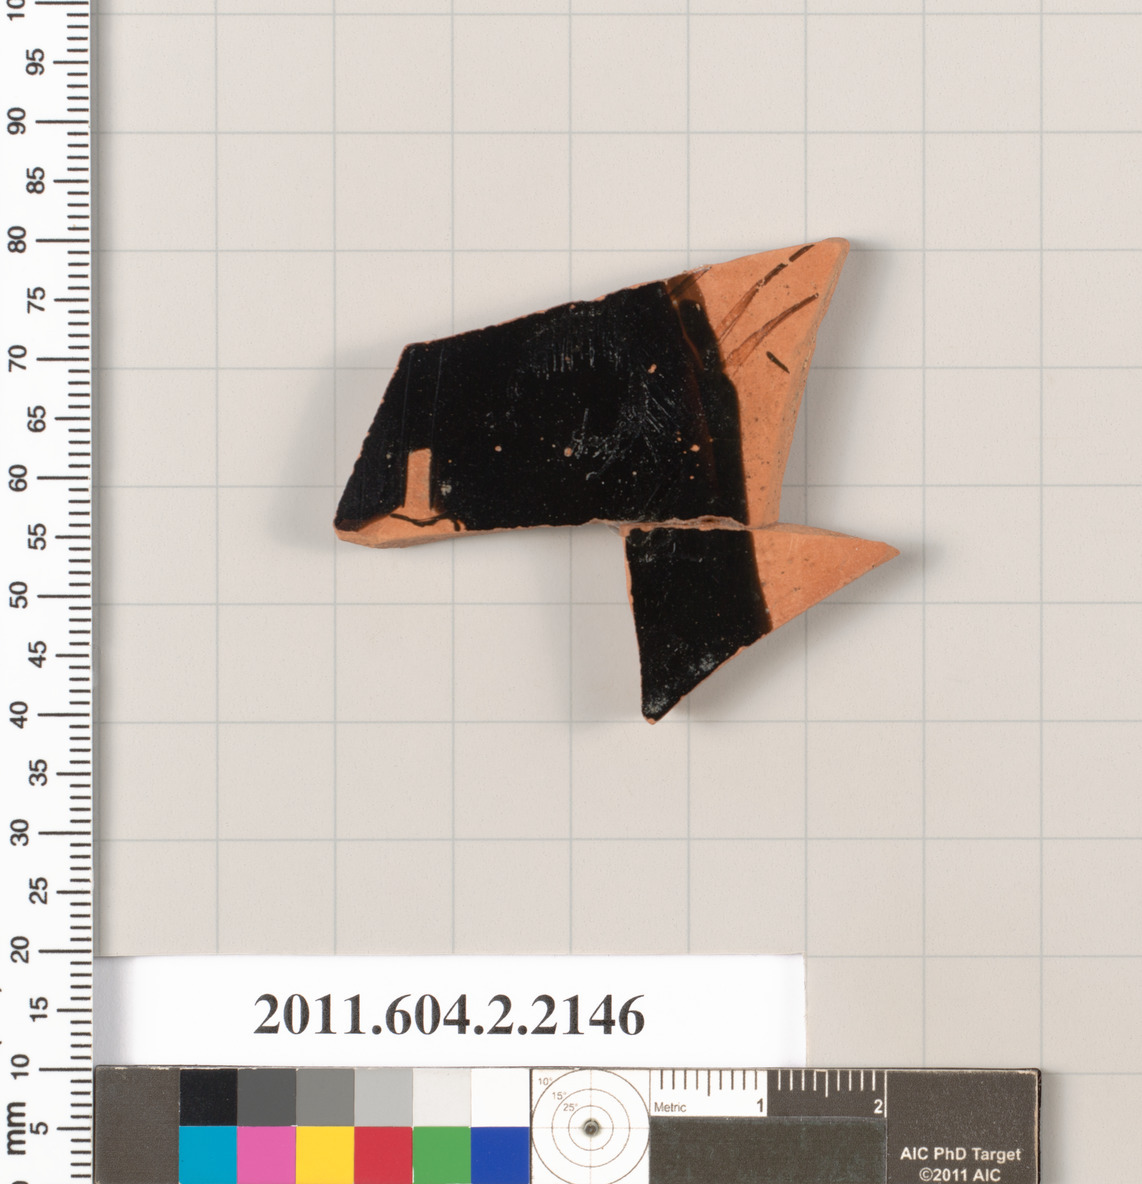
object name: pot fragment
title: Terracotta fragment of a pot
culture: greek, attic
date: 460-440 BCE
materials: terracotta